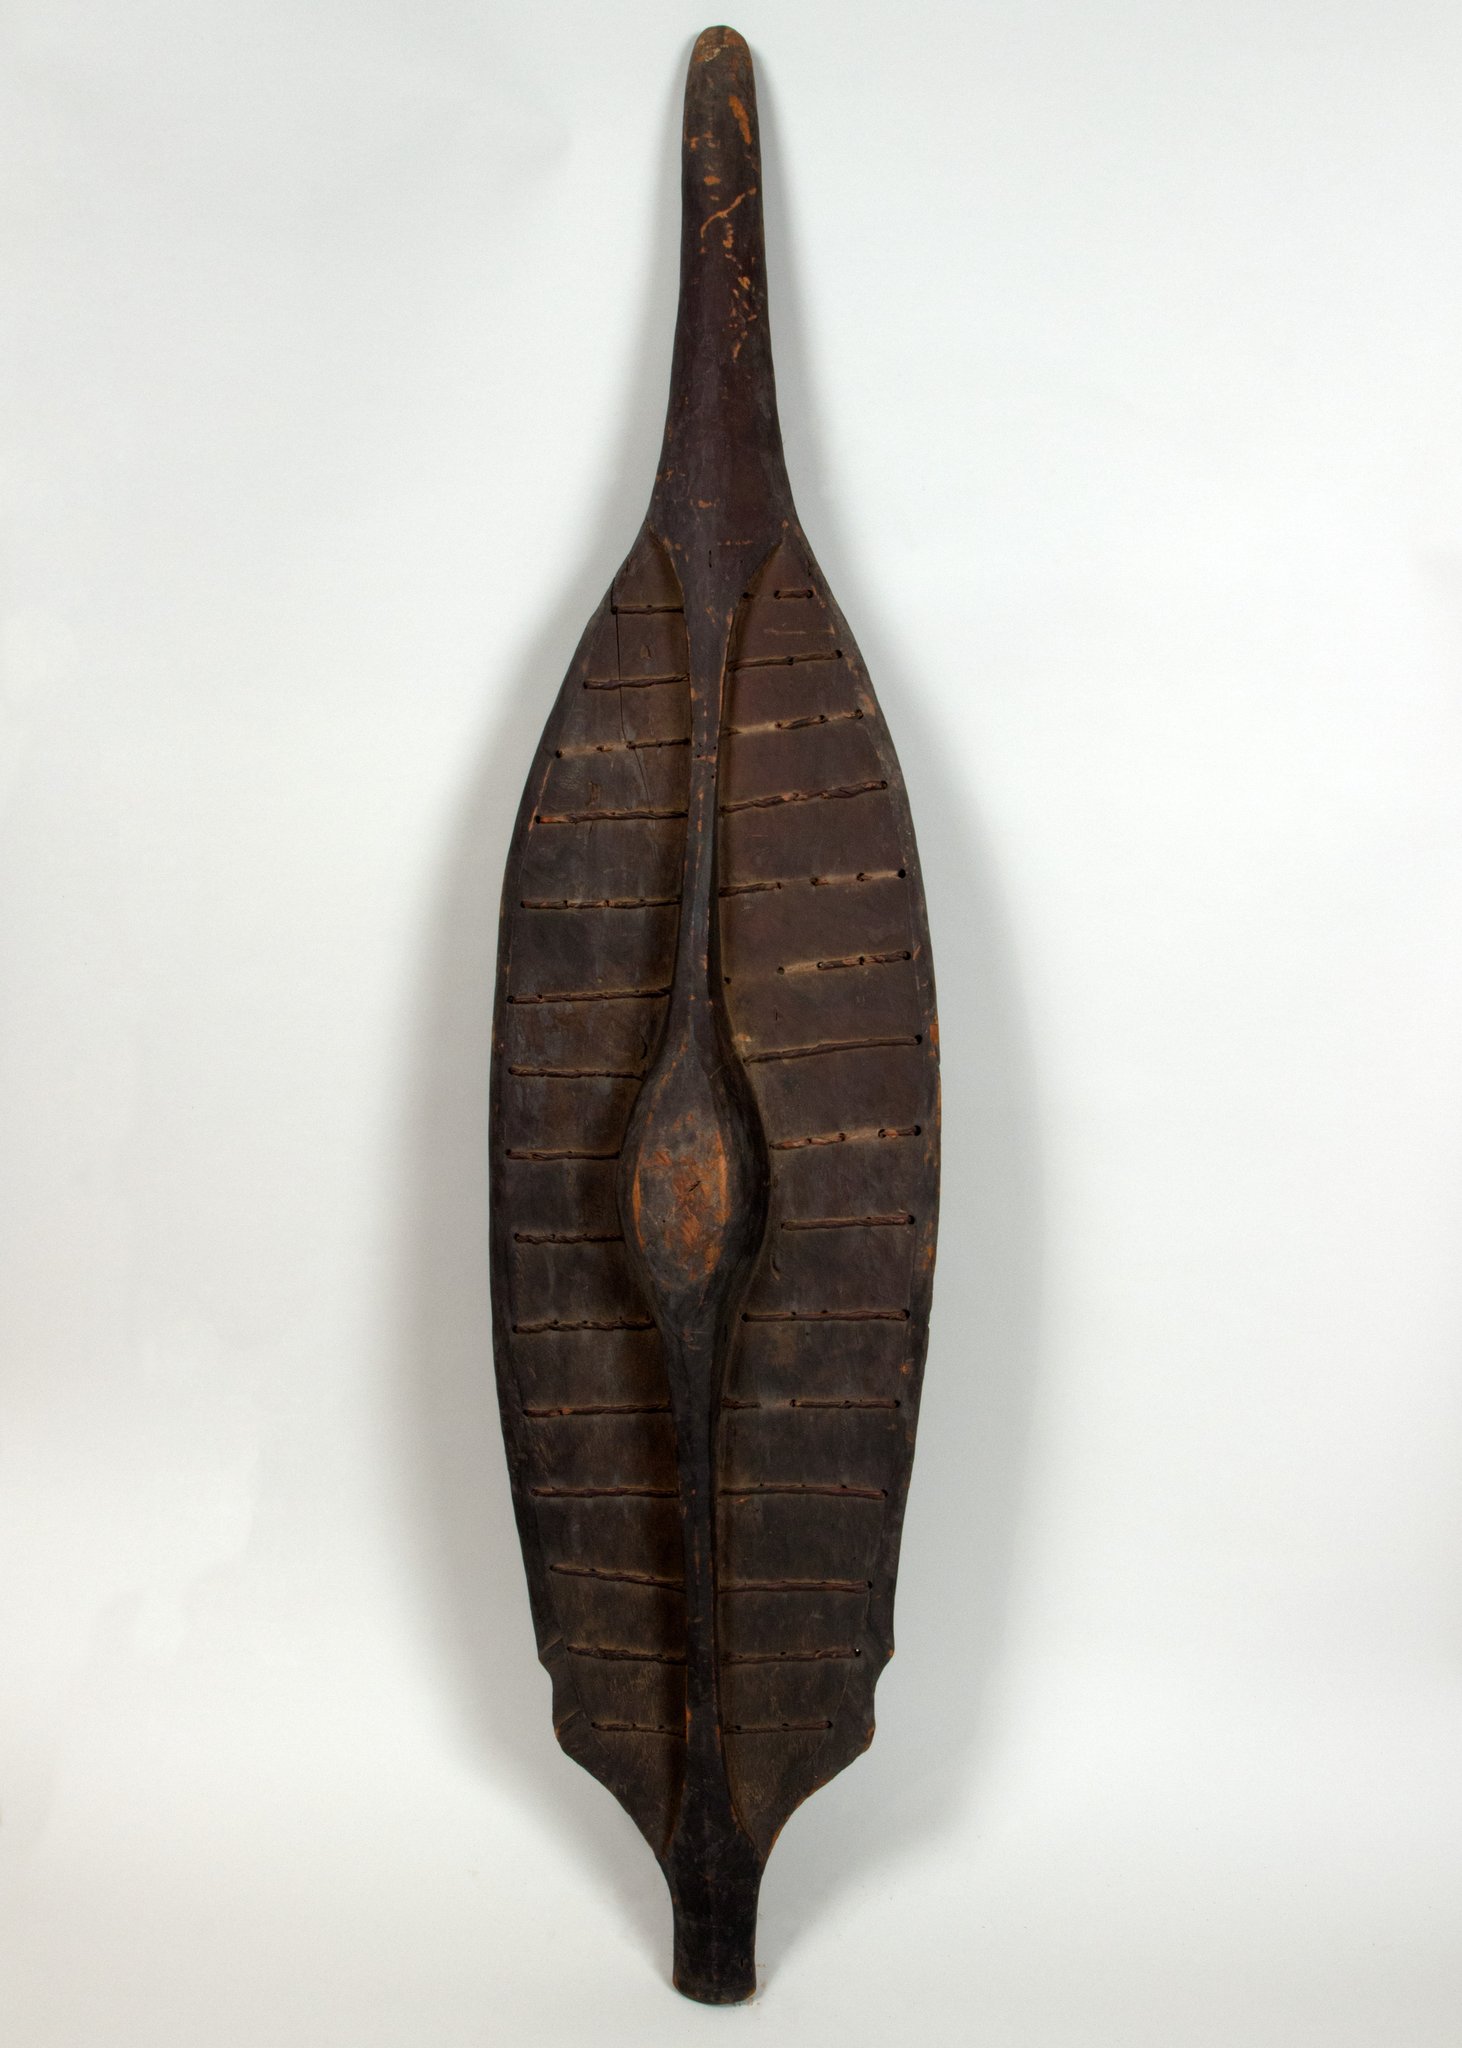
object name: shield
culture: nias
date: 1701-1900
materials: wood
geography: indonesia